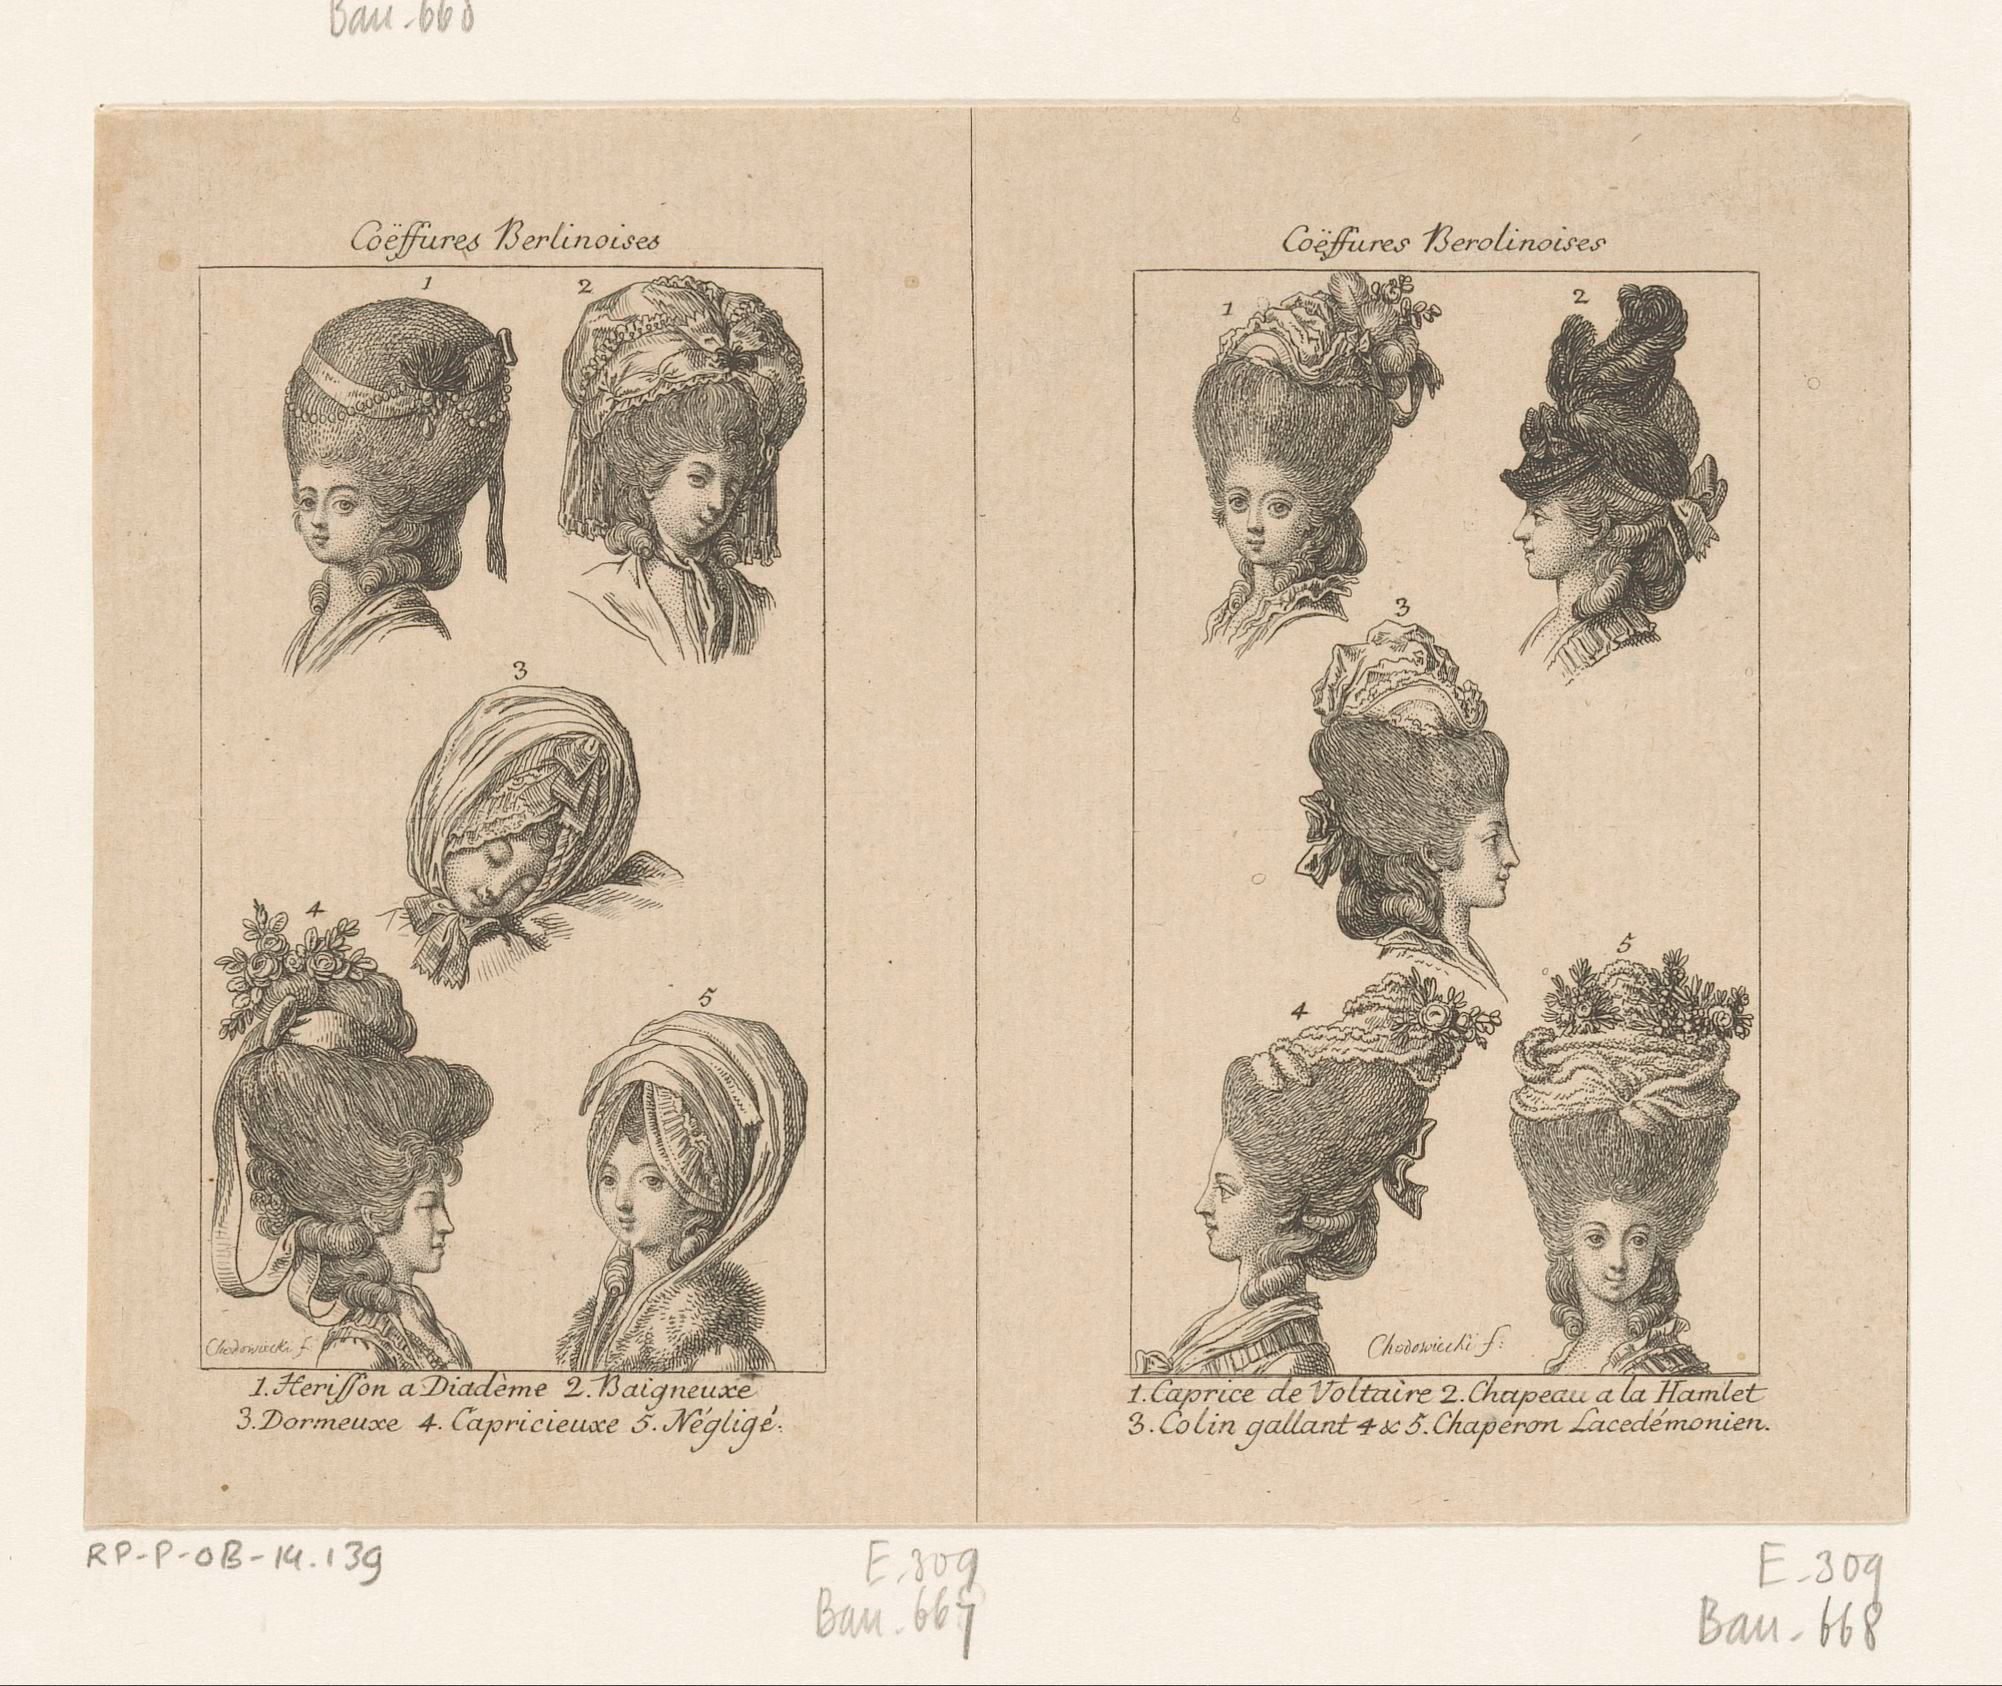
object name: print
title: Dameskapsels en hoofddeksels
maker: daniel nikolaus chodowiecki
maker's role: draughtsman, print maker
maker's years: 1726-1801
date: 1779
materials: paper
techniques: etching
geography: berlin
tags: head-gear (+ women's clothes), styles of hairdress - aa - ~ women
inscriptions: collector's mark: Lugt 2228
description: Deze prent is ook gebruikt in: Lauenburger genealogischen Kalender auf das Jahr 1780.